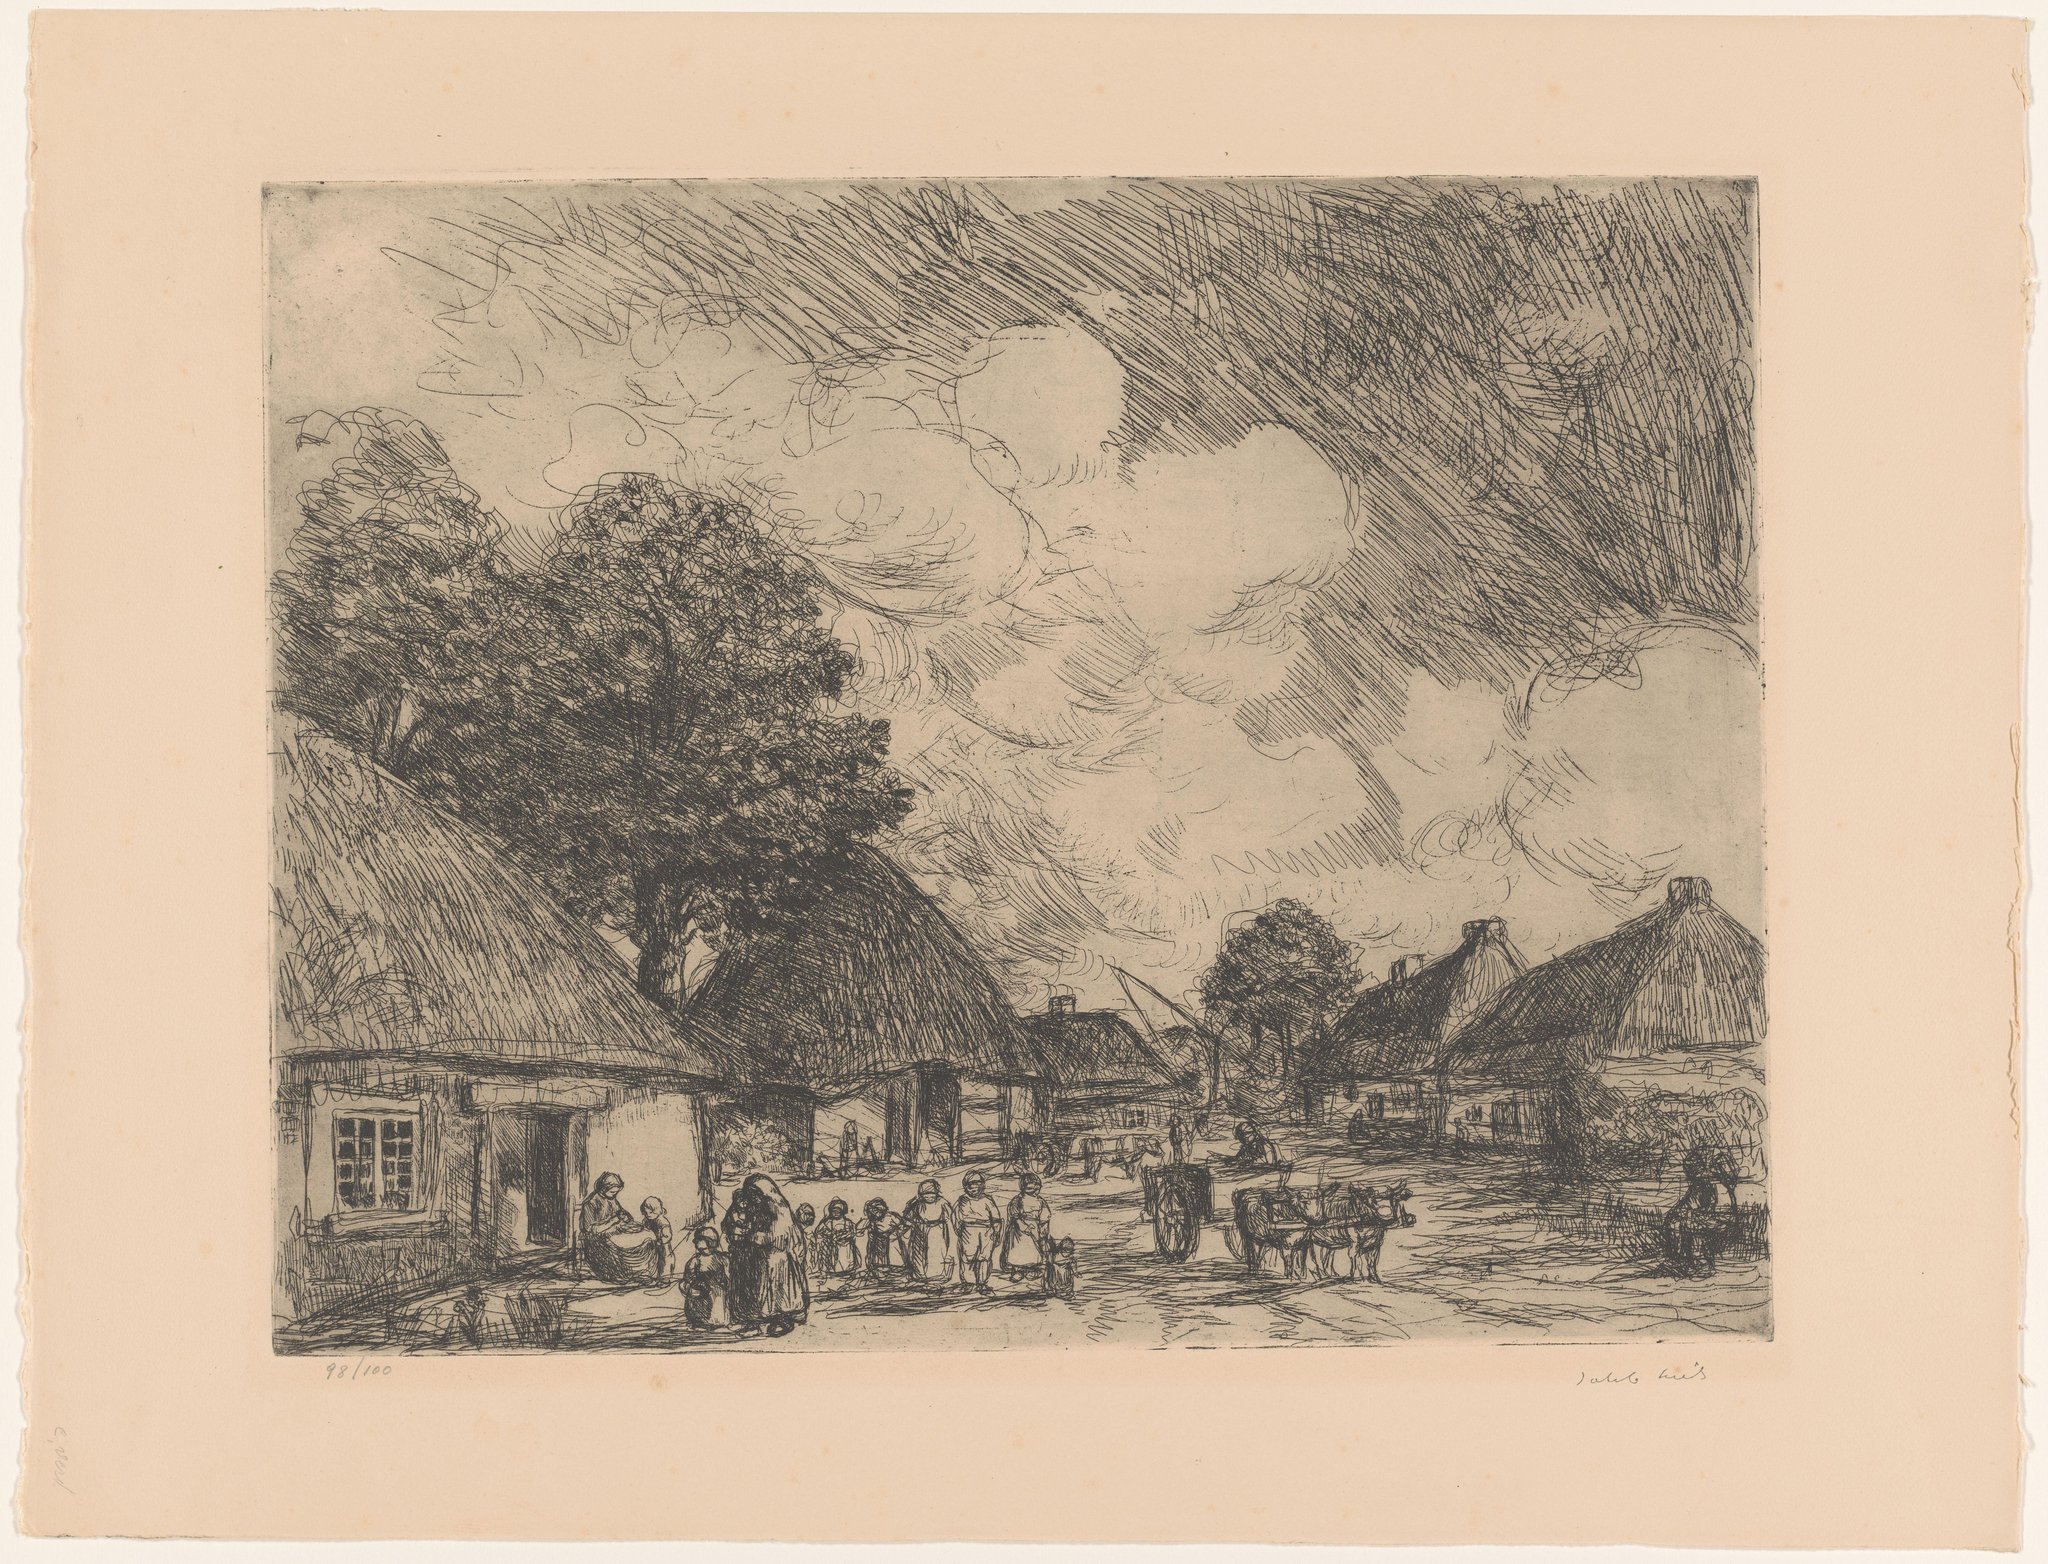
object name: print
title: Dorpsgezicht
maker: jakob smits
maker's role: draughtsman, print maker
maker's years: 1855-1928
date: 1865-1928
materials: paper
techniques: etching, intaglio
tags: village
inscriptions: collector's mark: Lugt 2228